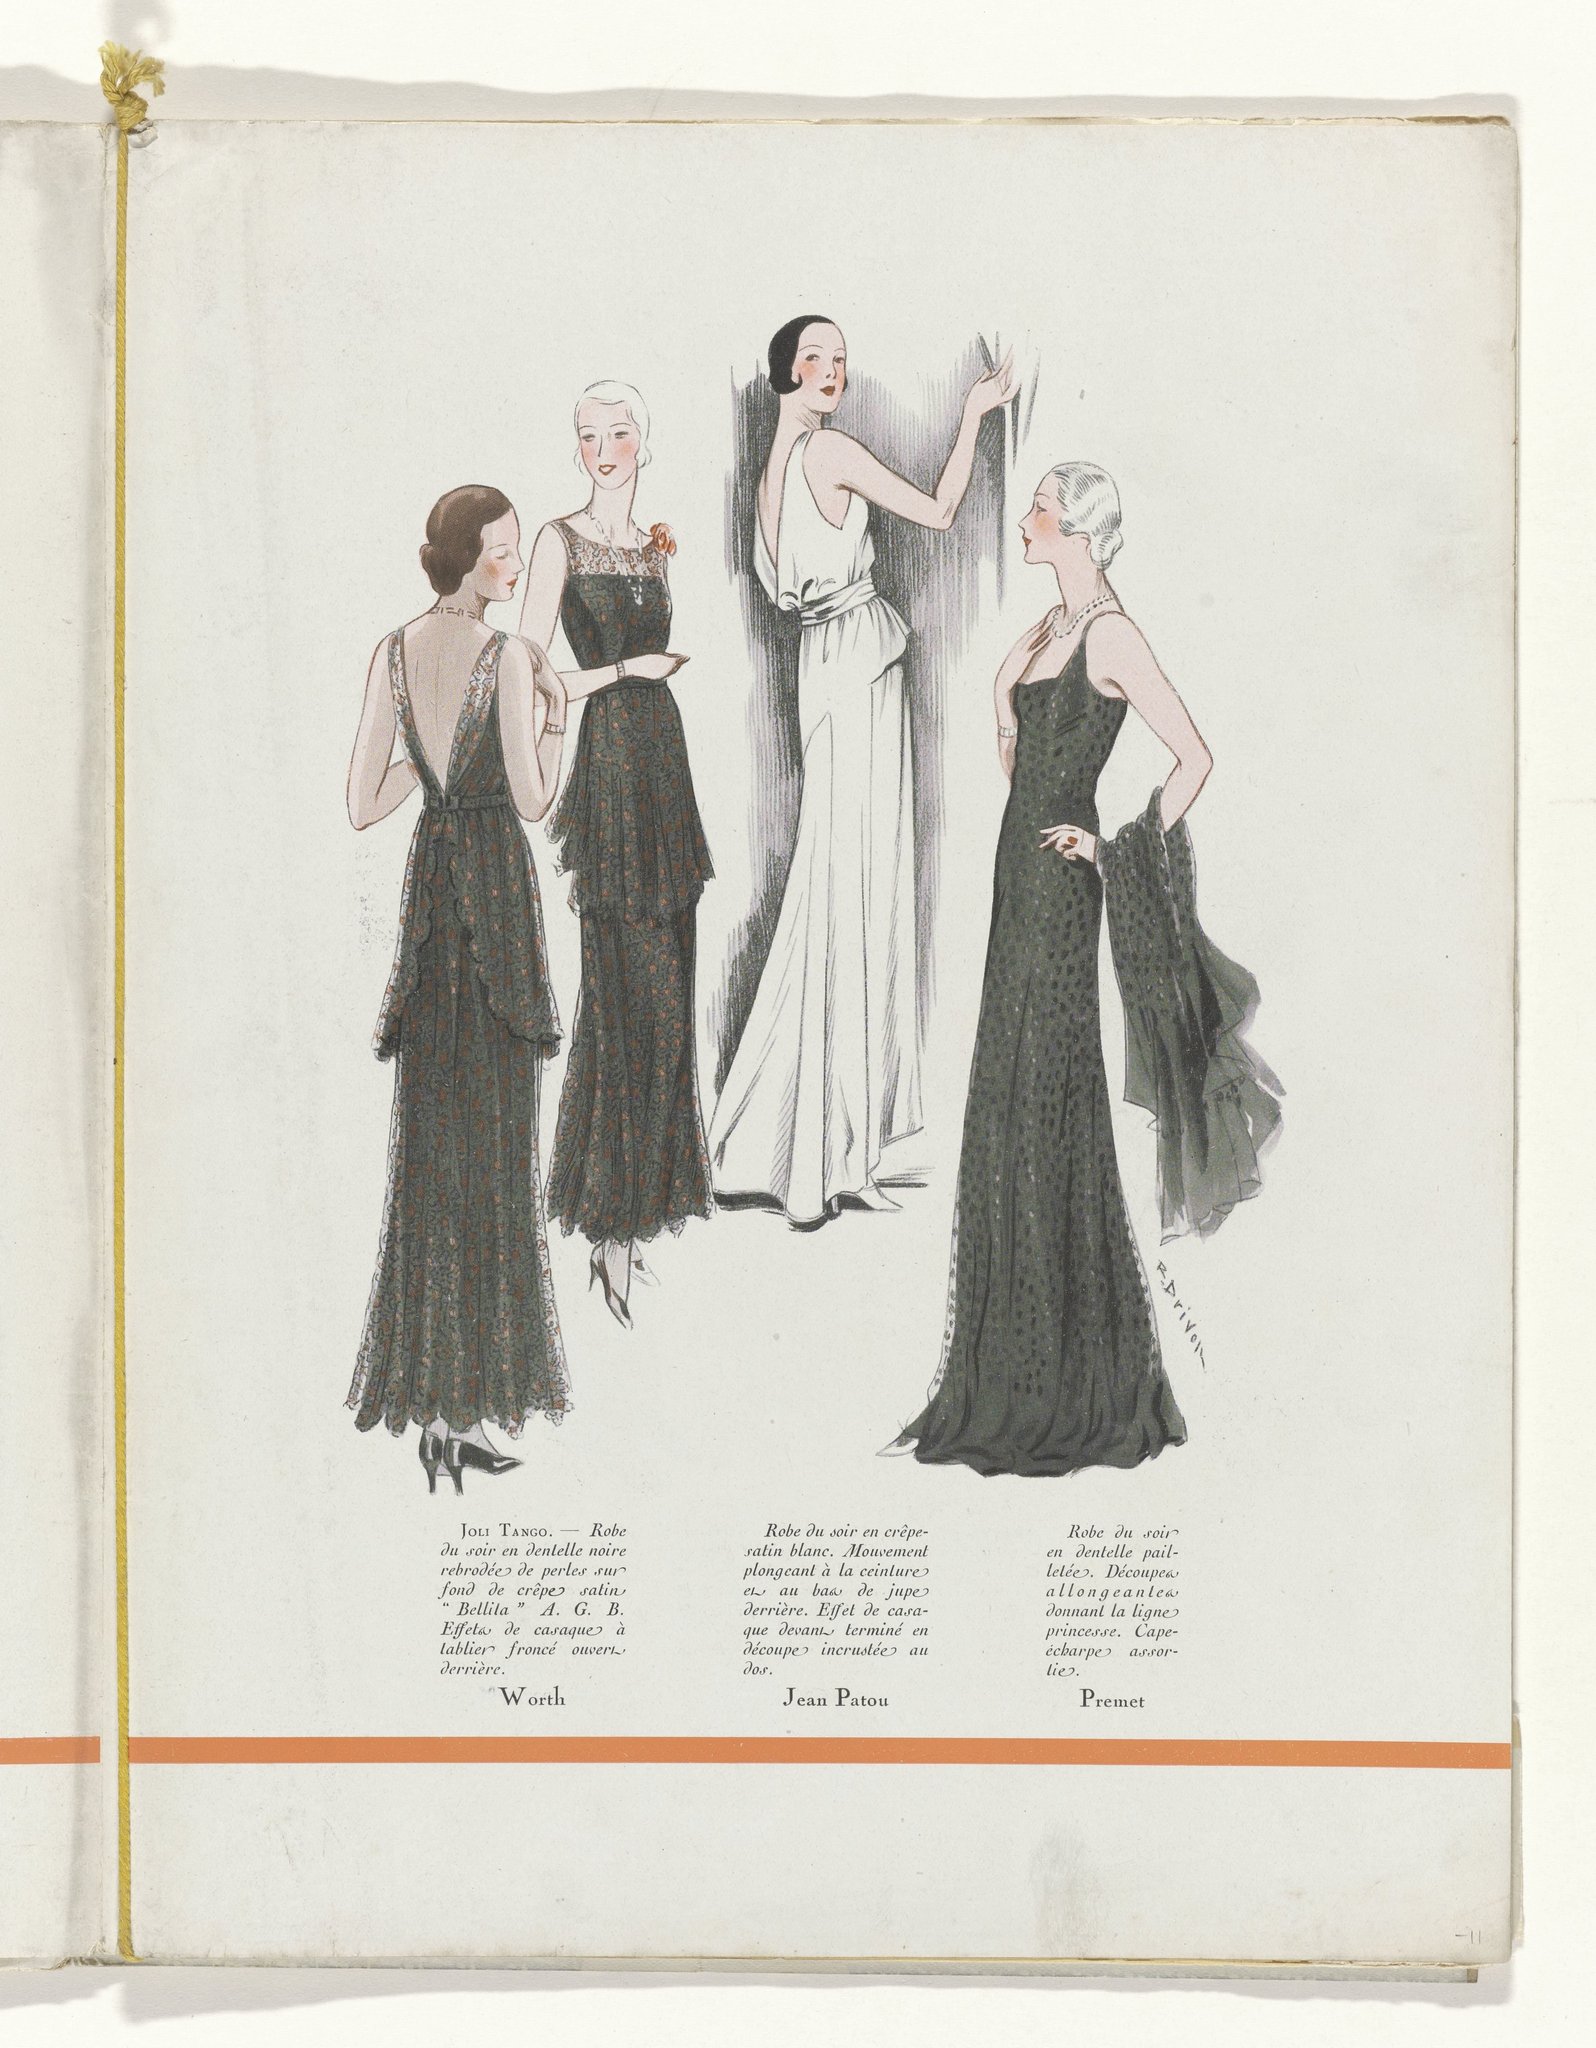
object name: magazine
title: Art - Goût - Beauté, Feuillets de l' élégance féminine, Mai 1931, No. 129, 11e Année, p. 11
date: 1931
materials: paper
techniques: printing, photography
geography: paris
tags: dress, gown: evening dress (+ women's clothes), clothing for the upper part of the body (shawl) (+ women's clothes), lace (+ women's clothes), fashion plates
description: Vier vrouwen, van wie er twee dezelfde avondjurk dragen. Links: avondjurk van zwart kant geborduurd met kralen op een ondergrond van 'crêpe satin' "Bellita" A.G.B., van Worth. Midden: avondjurk van witte crêpe satin, van Jean Patou. Rechts: avondjurk van kant met bijpassende sjaal, van Premet. Pagina uit het modetijdschrift Art-Goût-Beauté (1920-1933).